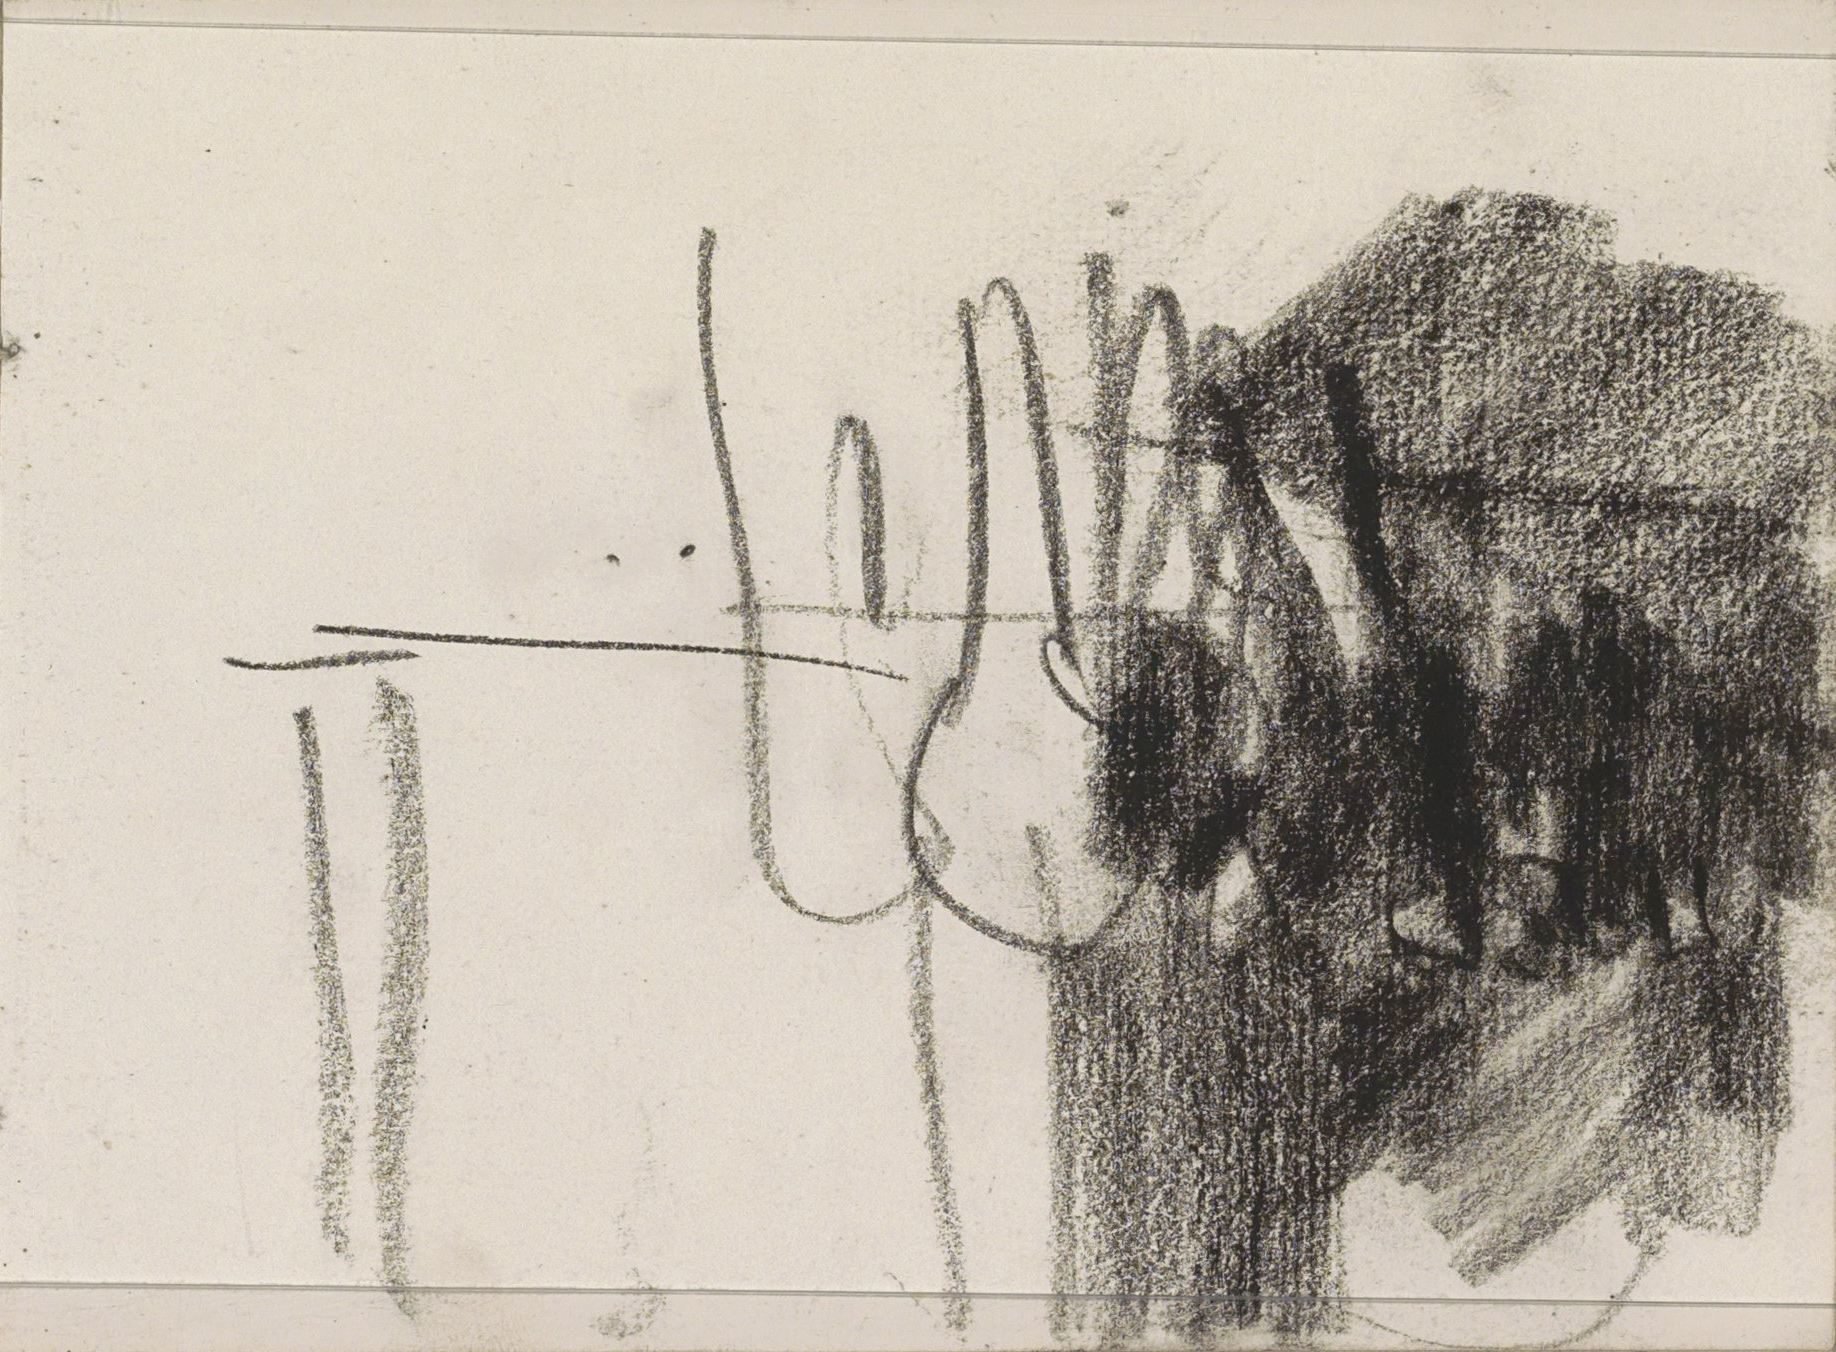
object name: sketchbook leaf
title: Studie, mogelijk van figuren op straat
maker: isaac israels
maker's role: draughtsman, painter, print maker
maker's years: 1865-1934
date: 1886-1903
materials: chalk, paper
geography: amsterdam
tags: street (+ city(-scape) with figures, staffage)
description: Pagina 9 uit schetsboek XLVII met 52 pagina's.